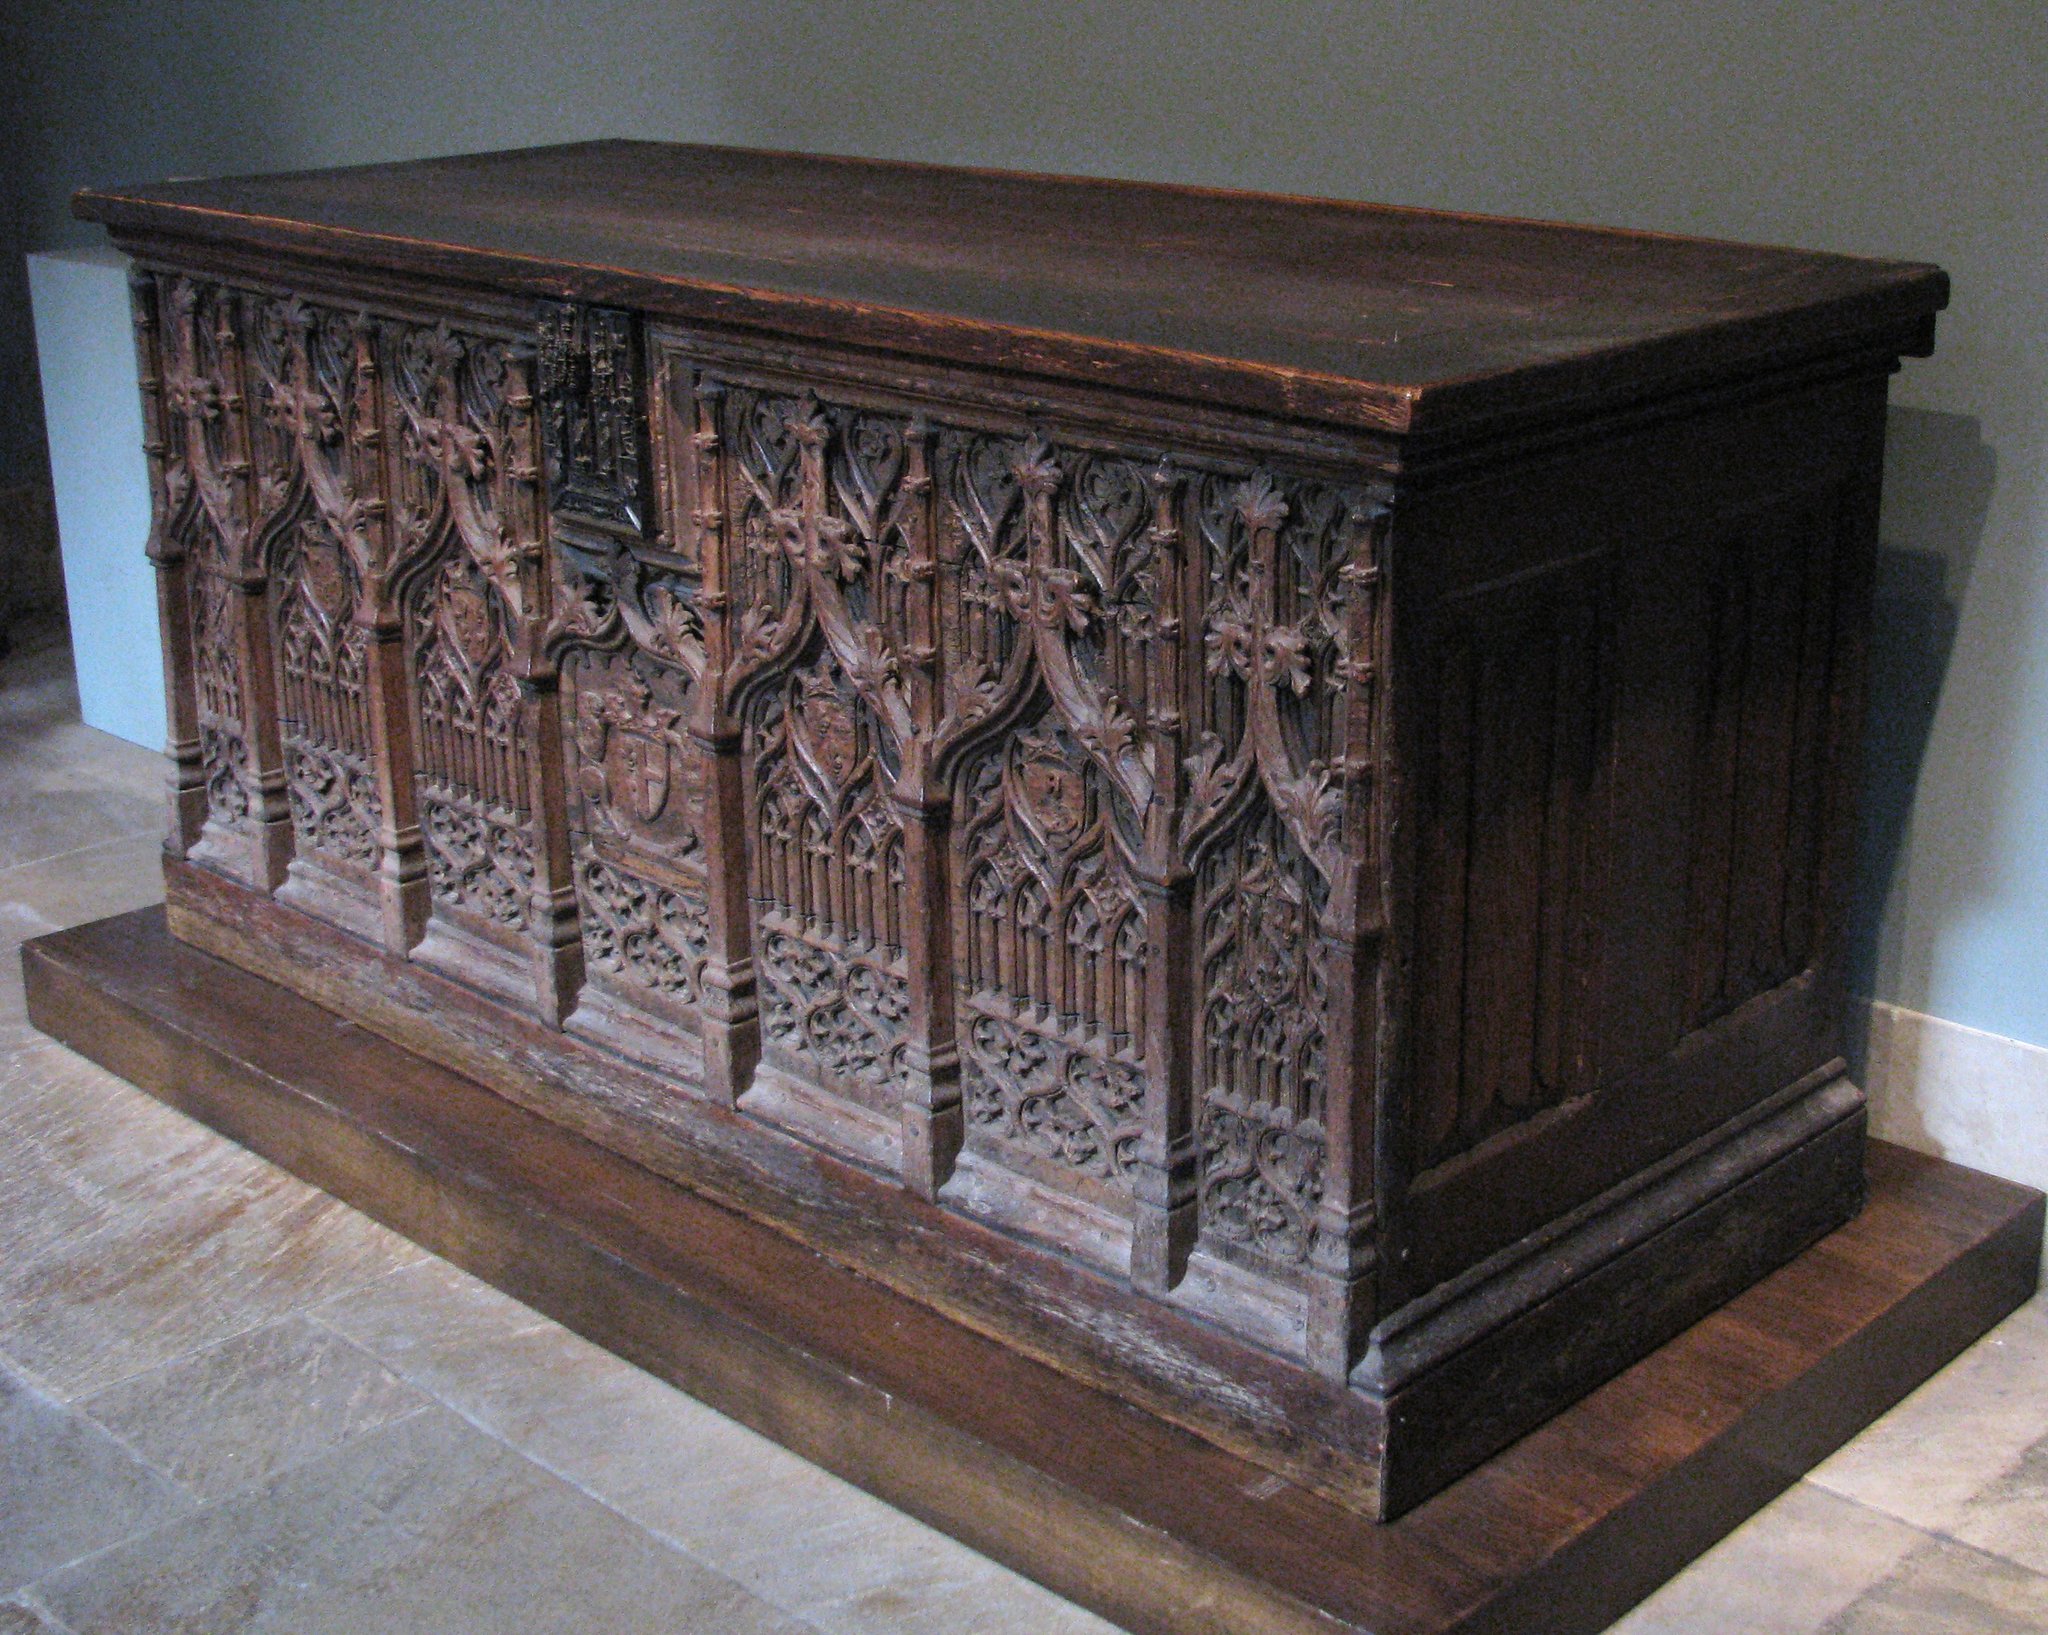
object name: chest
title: Chest with Coats of Arms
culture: french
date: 1501-1533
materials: iron, wood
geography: france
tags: coat of arms